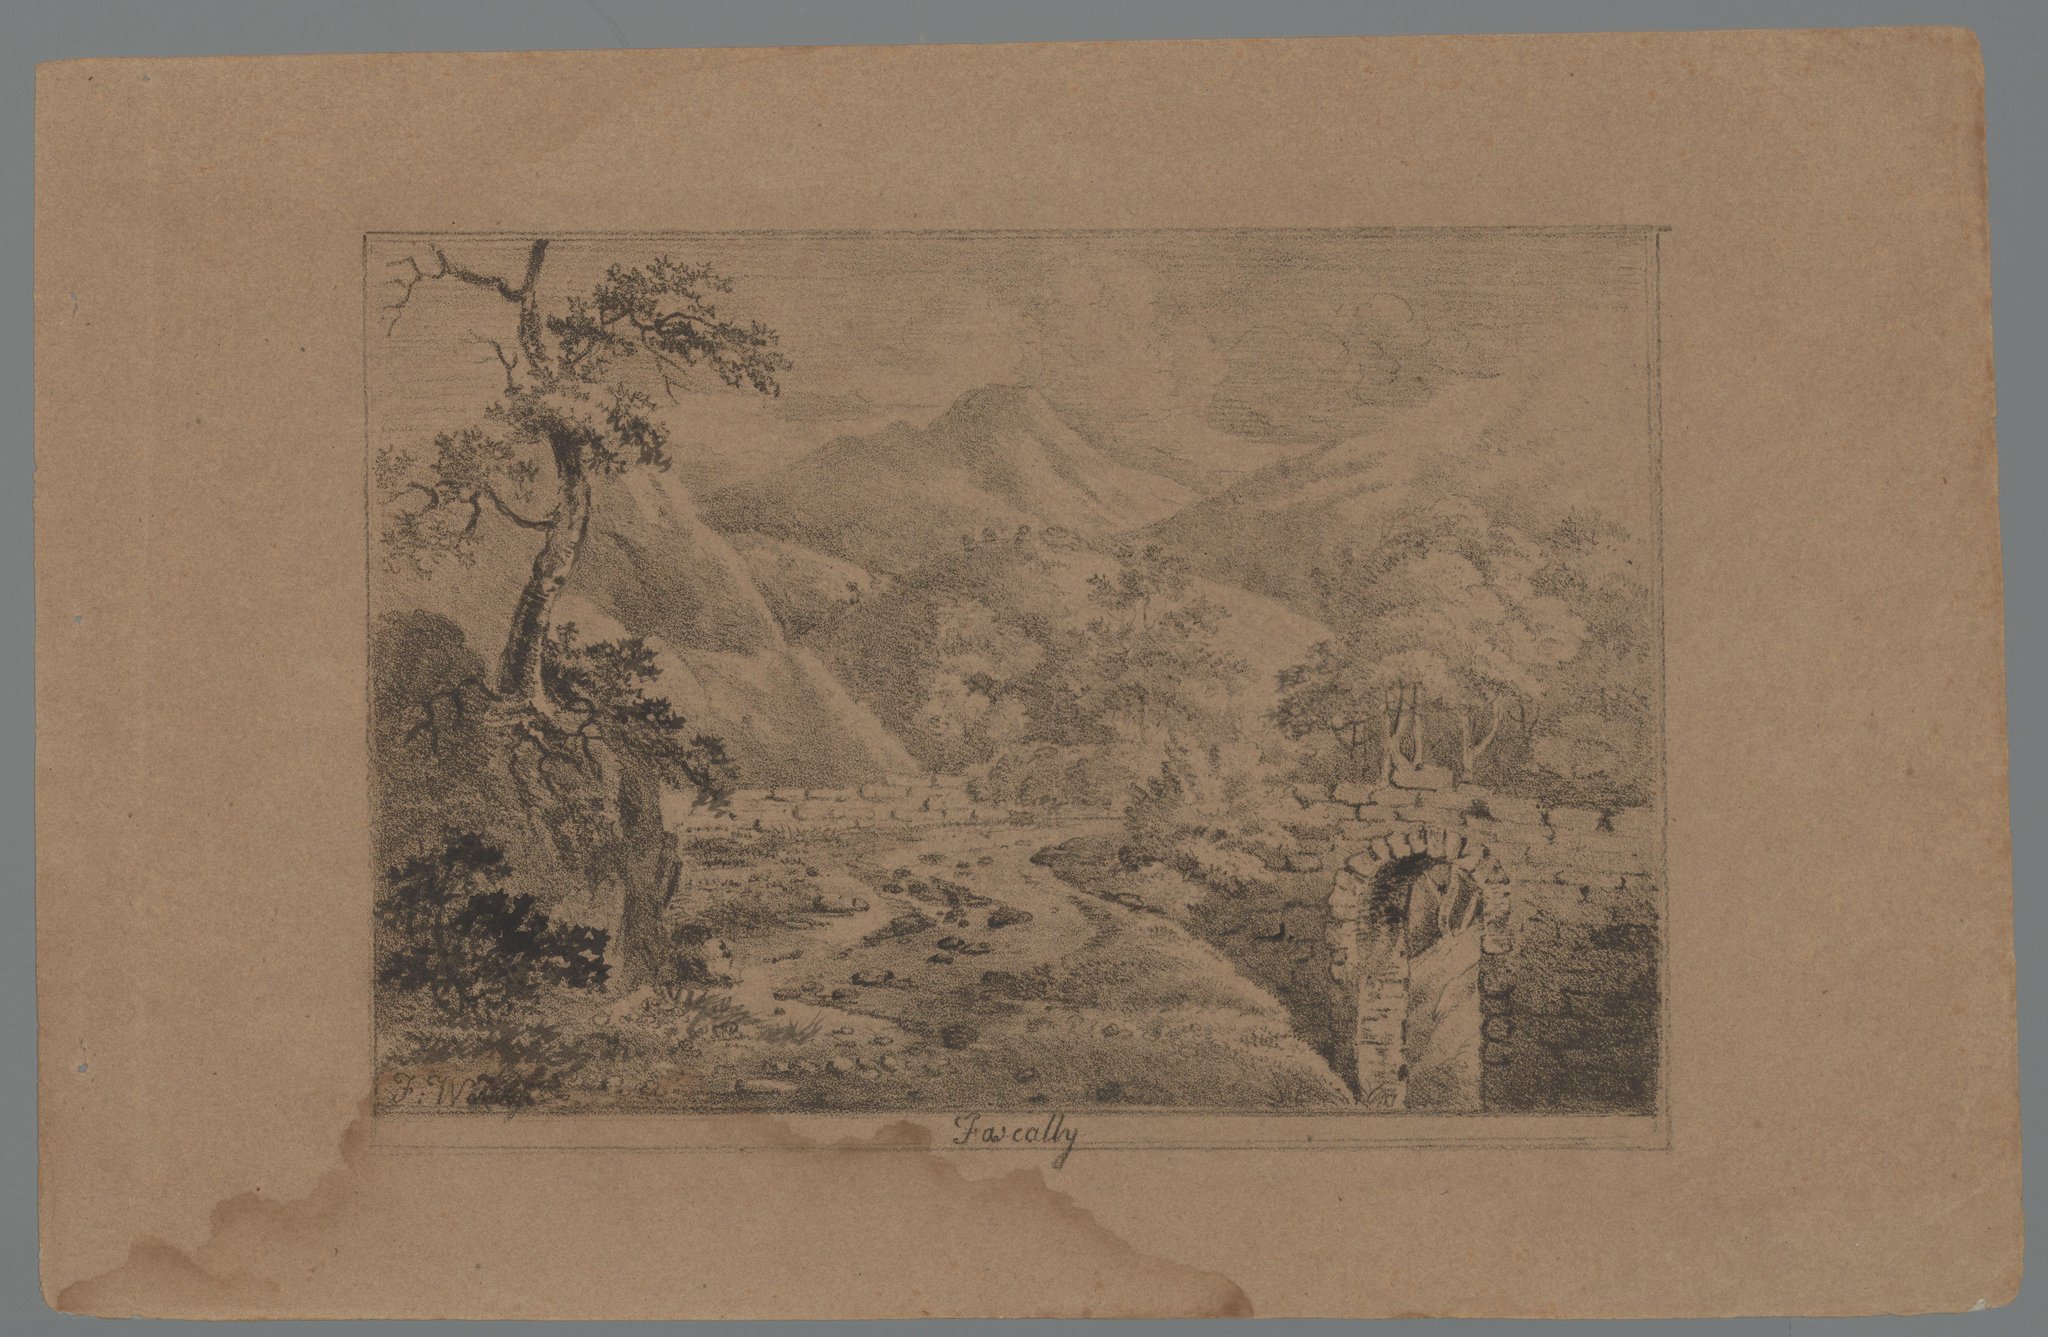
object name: print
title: Fascally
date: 1803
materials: ink, paper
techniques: brush, lithograph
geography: london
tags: landscapes in the temperate zone, road, path, mountains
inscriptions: collector's mark: Lugt 2233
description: Deze prent behoort tot de serie 'Twelve views in Scotland, delineated by a lady in the polyautographic art of drawing on stone'. Deze serie met twaalf lithografieën is een van de vroegste reeksen lithografieën in Groot-Brittannië.